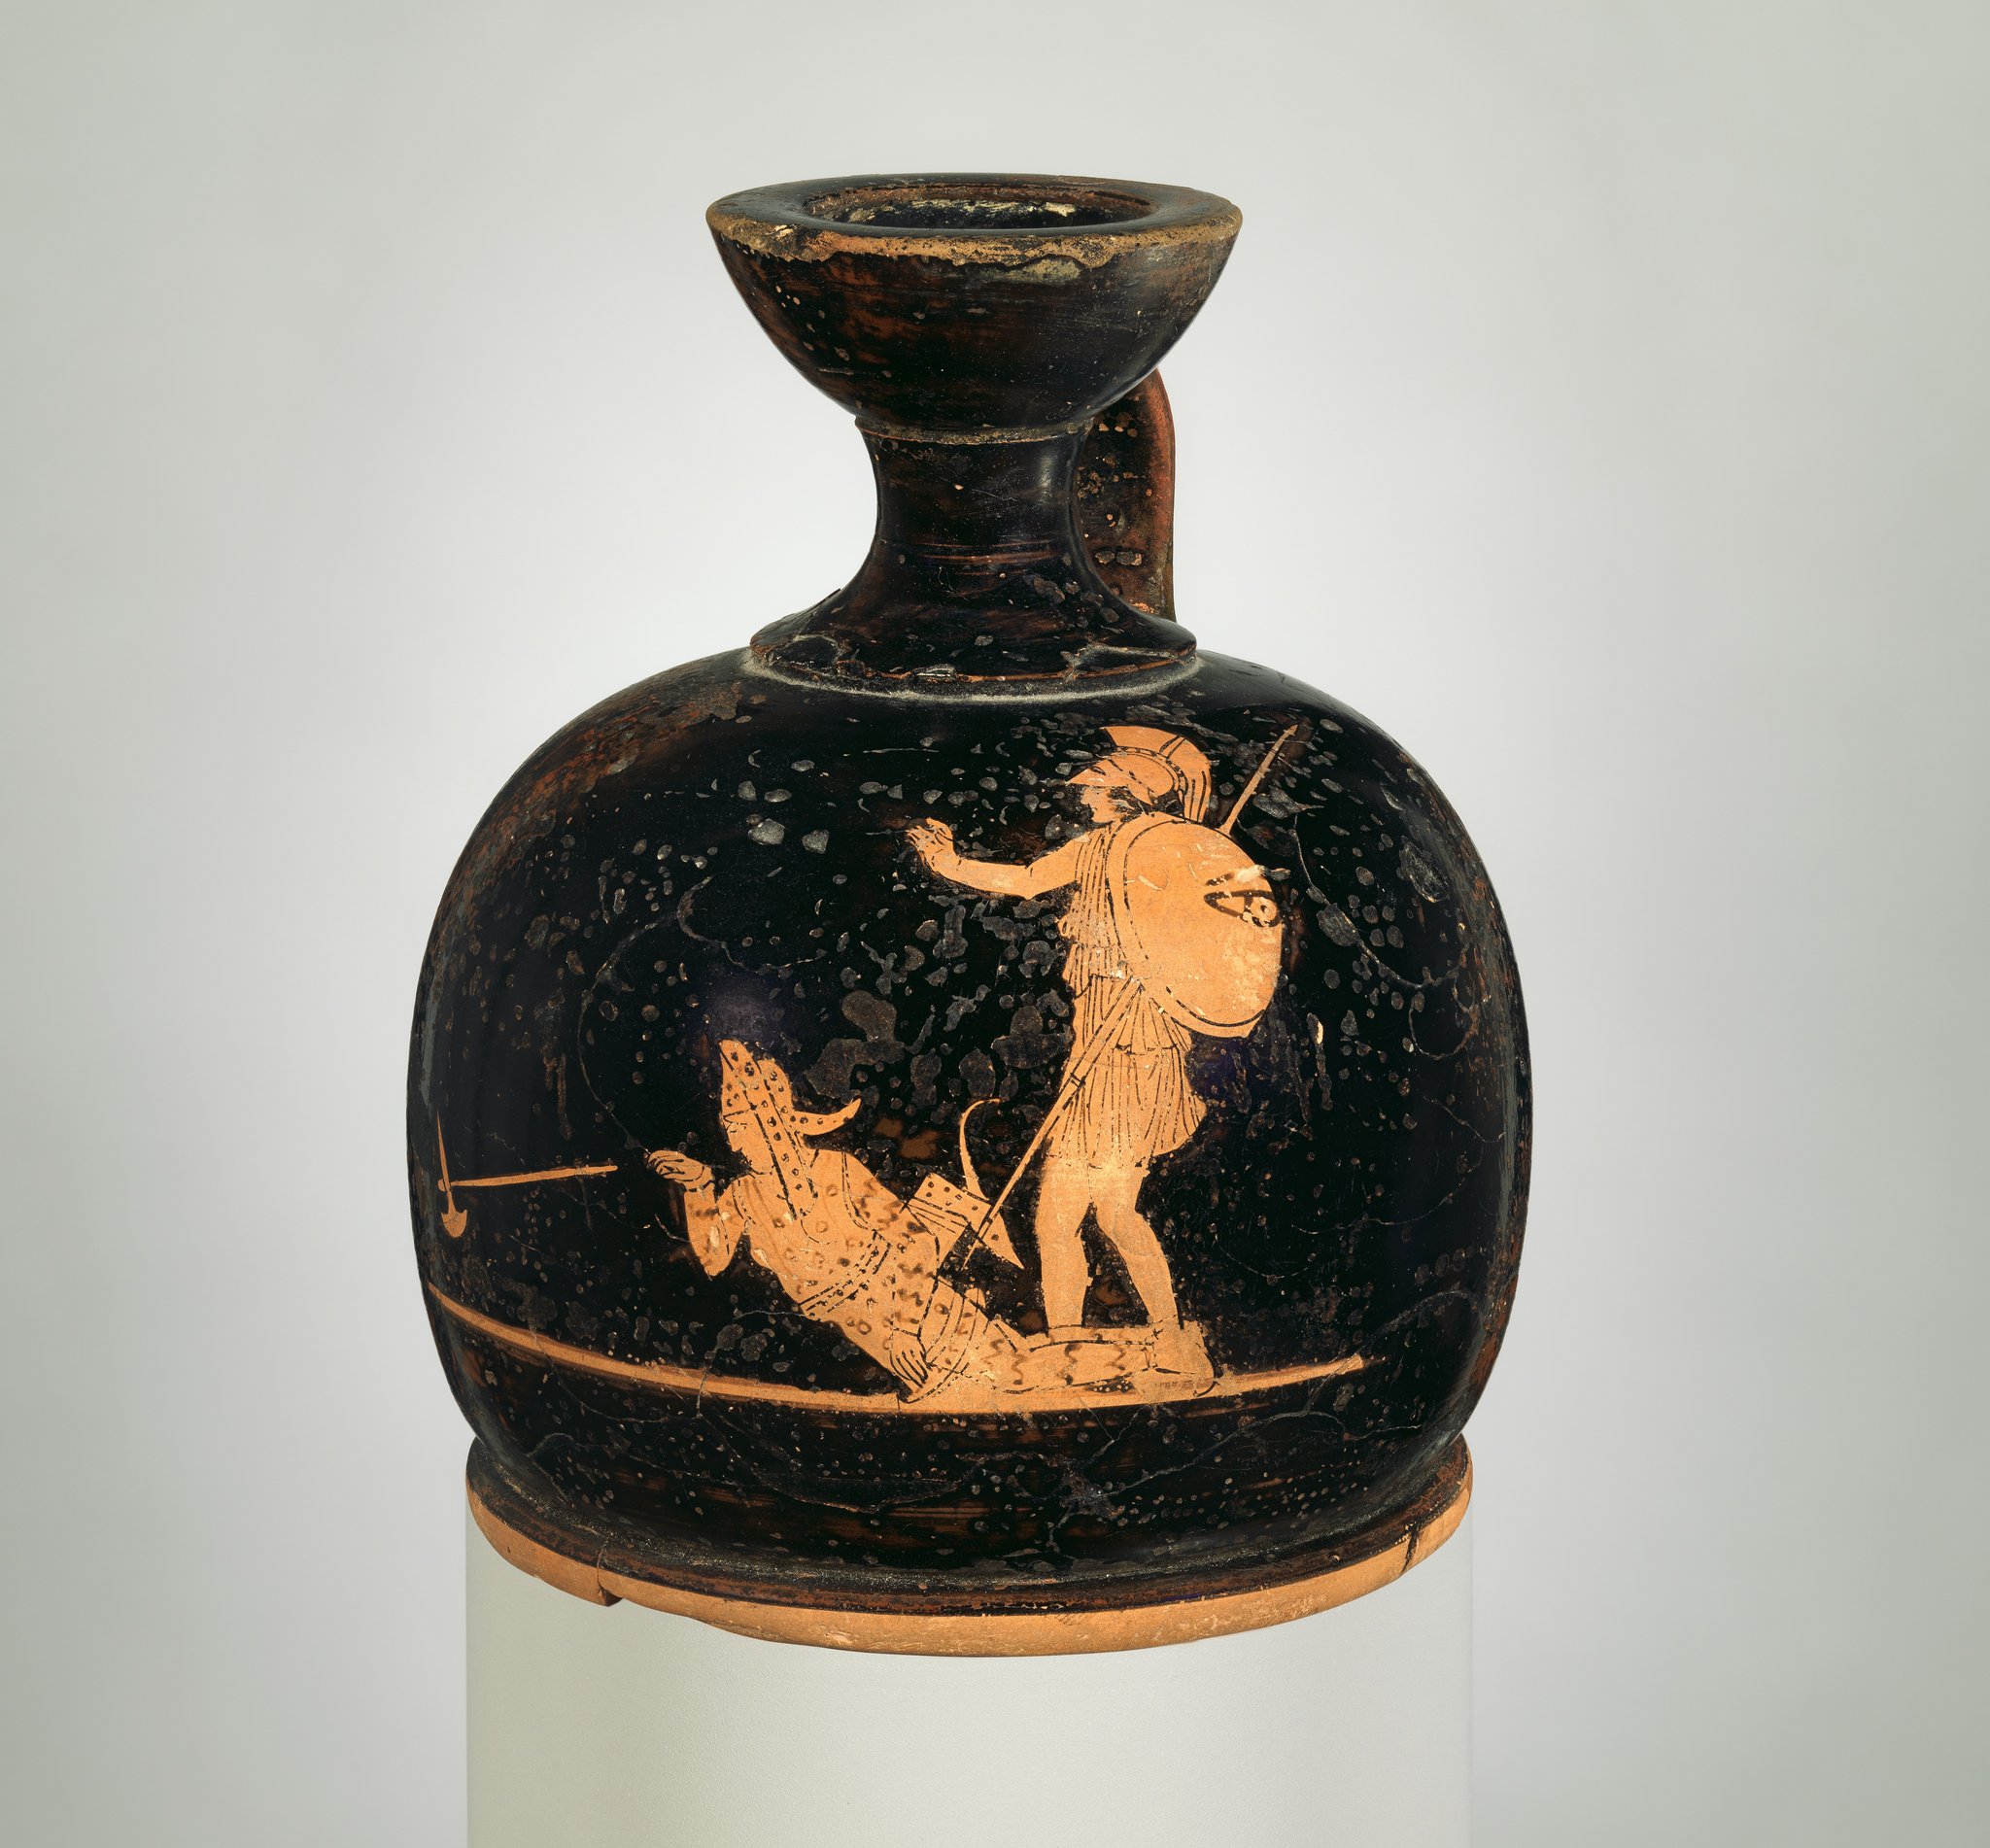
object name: squat lekythos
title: Terracotta squat lekythos (oil flask)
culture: greek, attic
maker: painter of munich 2363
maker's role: artist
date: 440-430 BCE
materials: terracotta